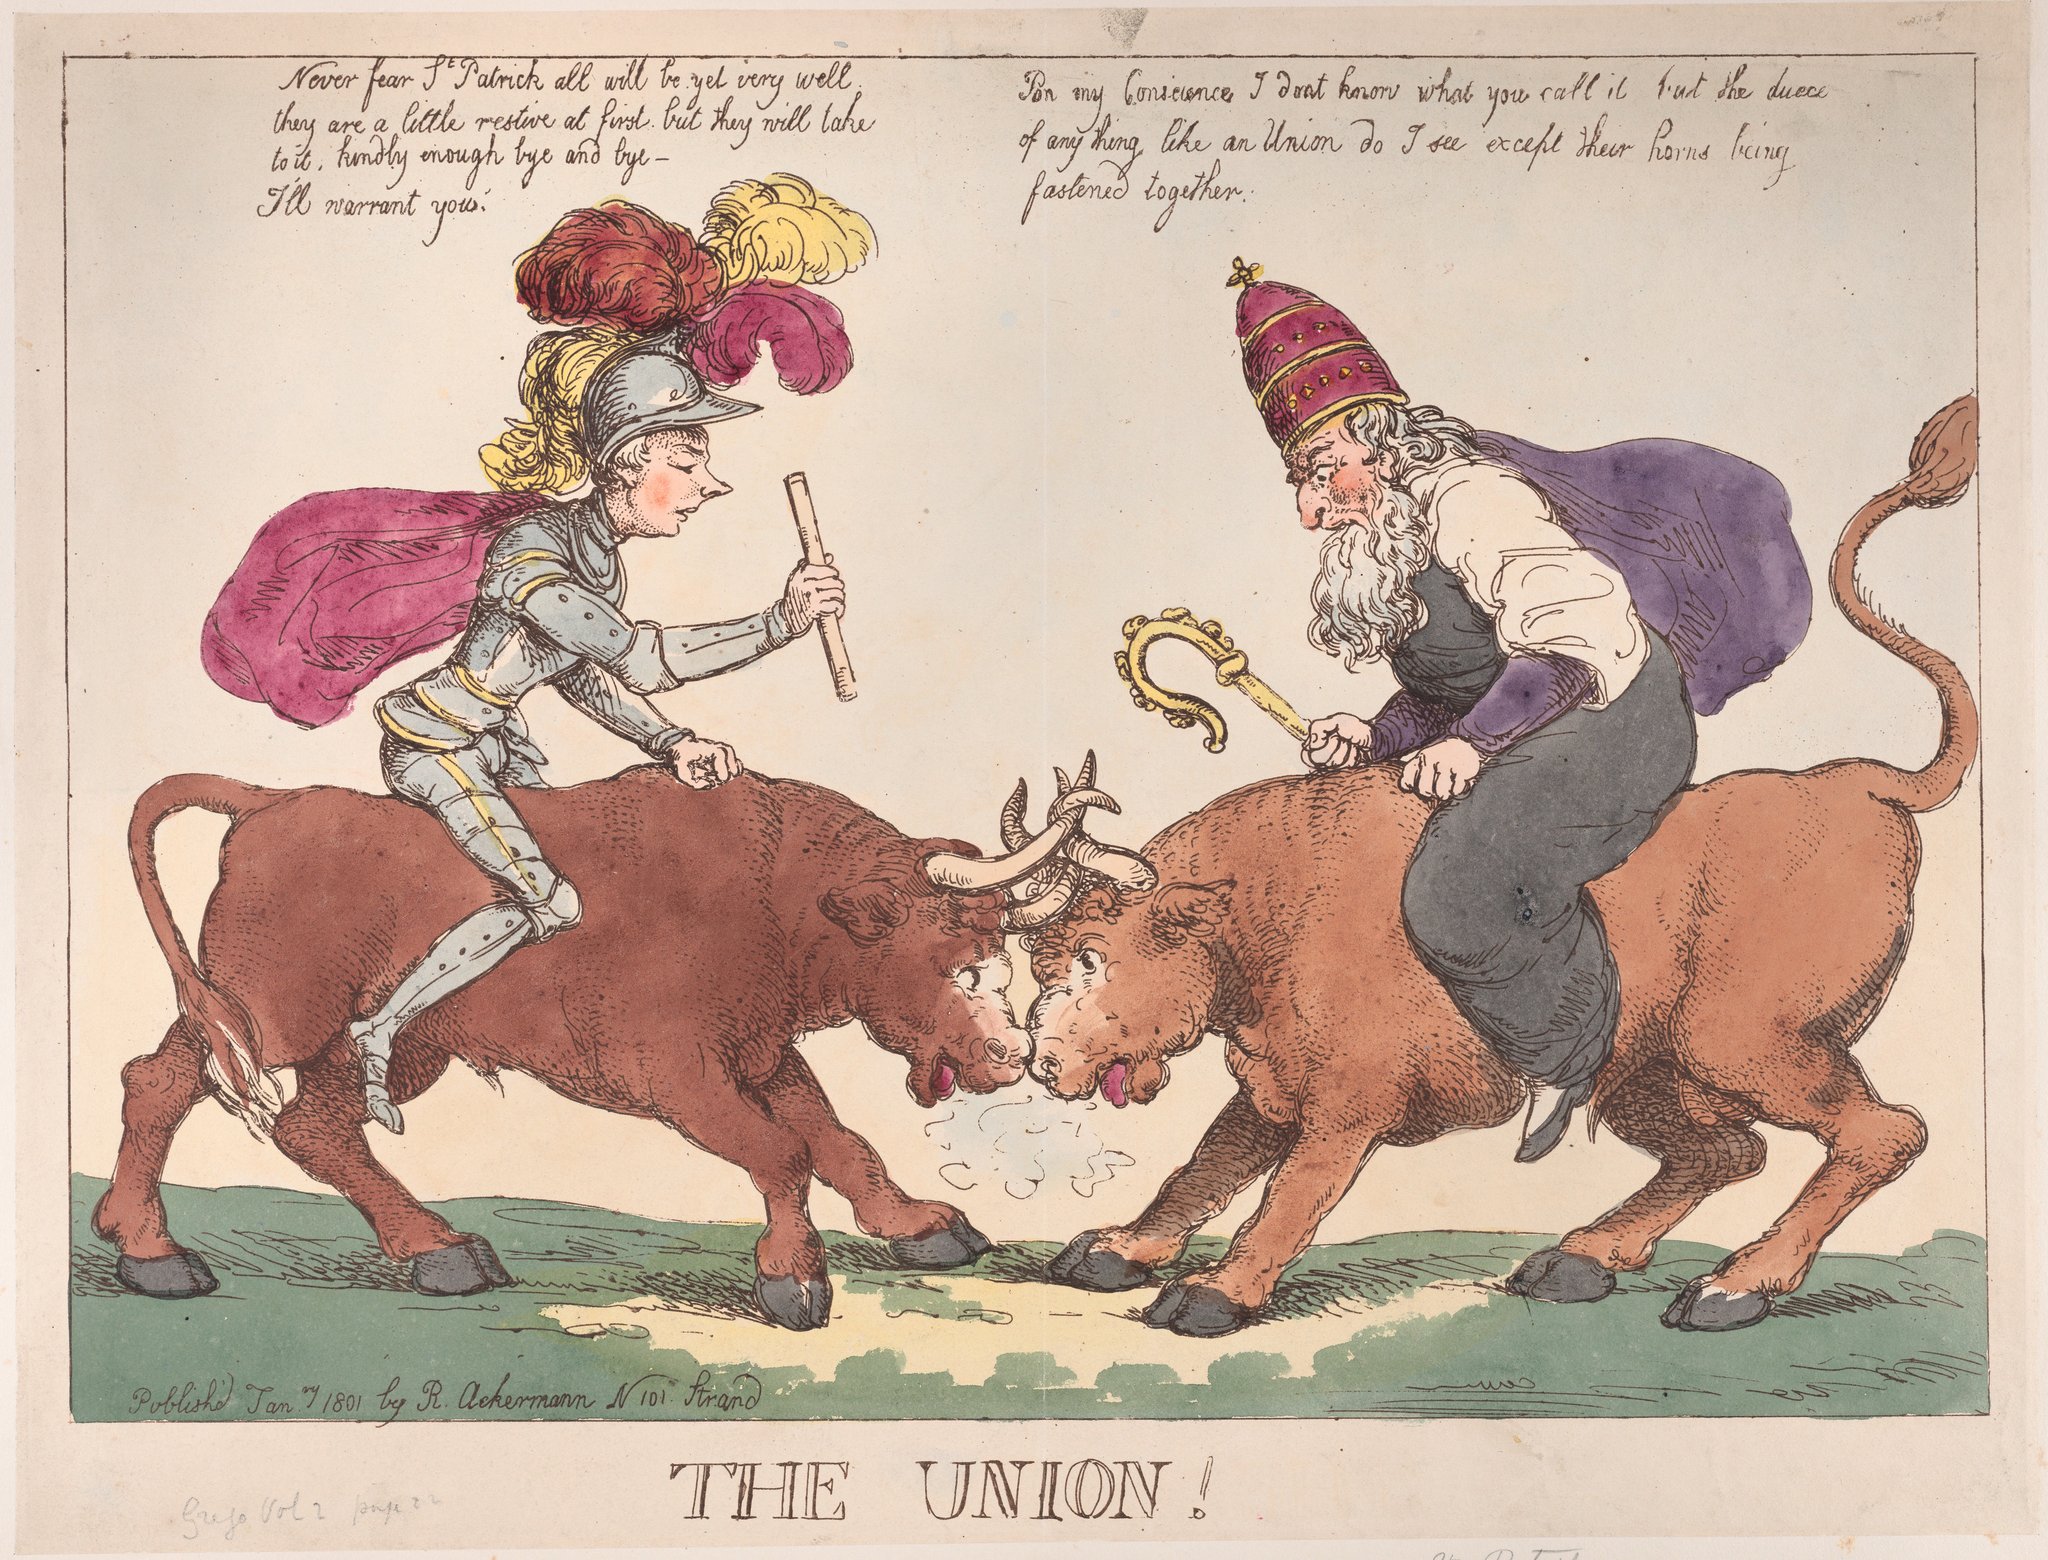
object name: print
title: The Union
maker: thomas rowlandson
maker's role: artist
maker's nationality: british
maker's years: 1757-1827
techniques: etching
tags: satire,men,bulls,politics